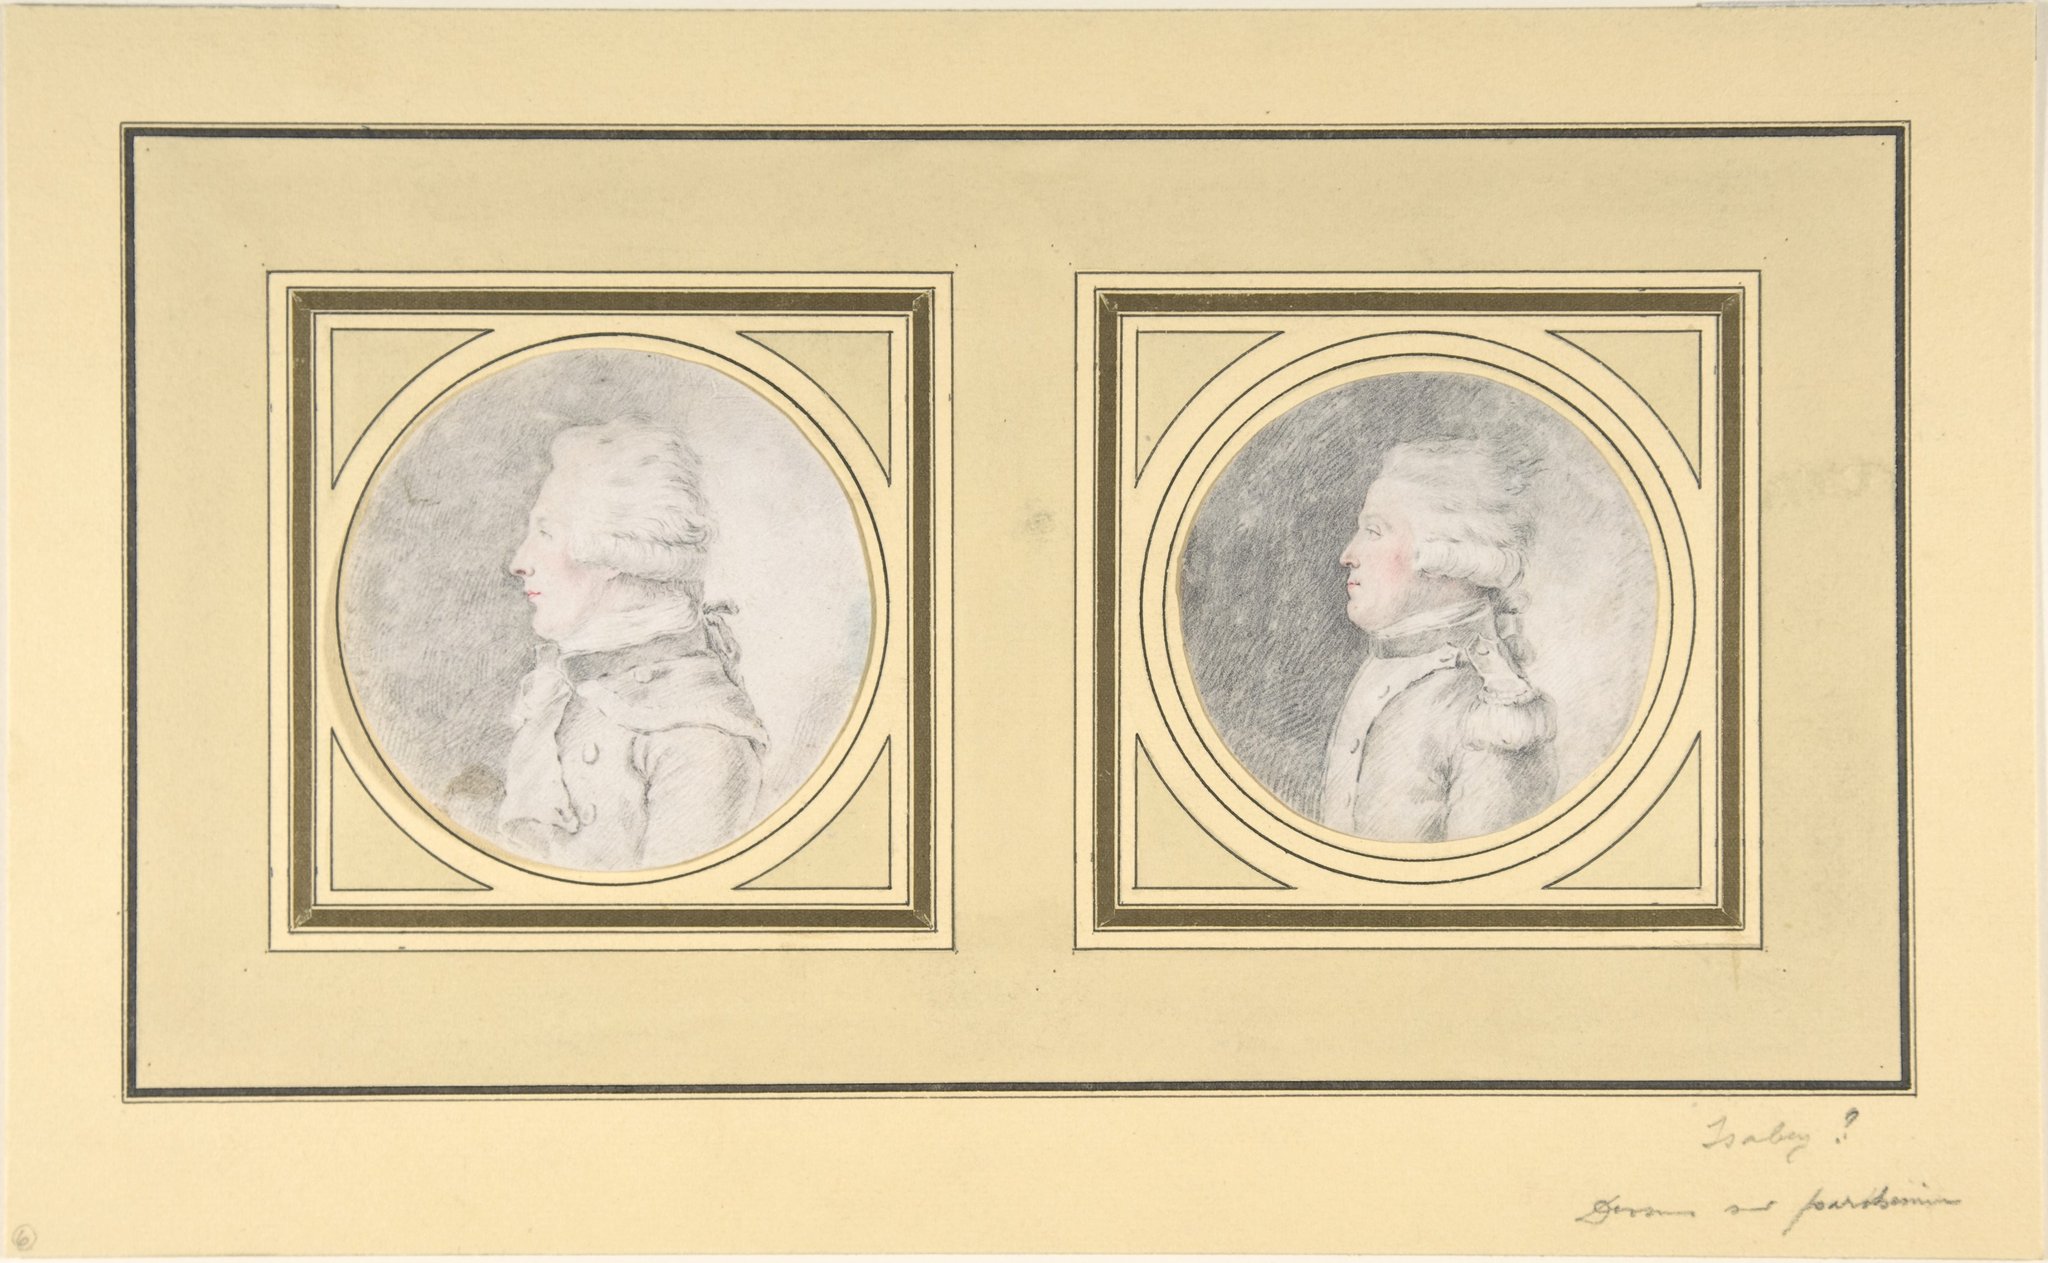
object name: drawing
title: Drawings for Portrait Engraving of a Man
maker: anonymous, french, 18th century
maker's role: artist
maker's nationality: french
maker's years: 1700-1800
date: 1767-1800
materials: graphite, pencil, parchment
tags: men,profiles